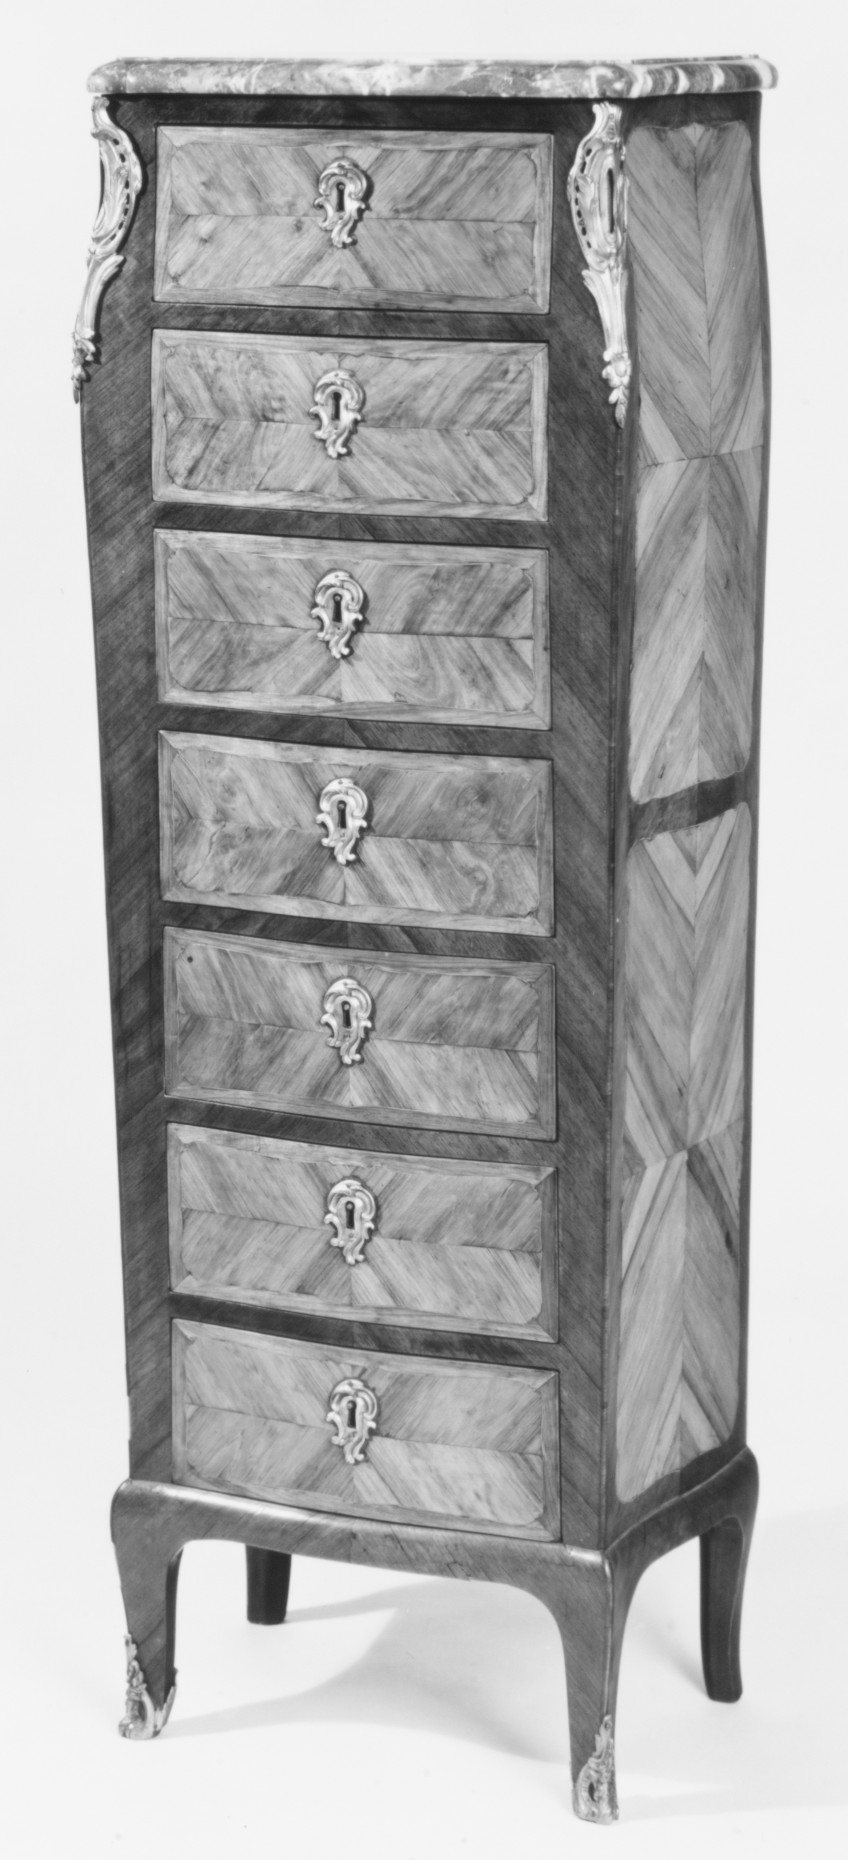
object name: chest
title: Chest (chiffonier) (one of a pair)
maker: bernard ii van risenburgh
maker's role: maker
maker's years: 1696-1767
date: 1765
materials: gilt bronze, marble, wood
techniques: veneering